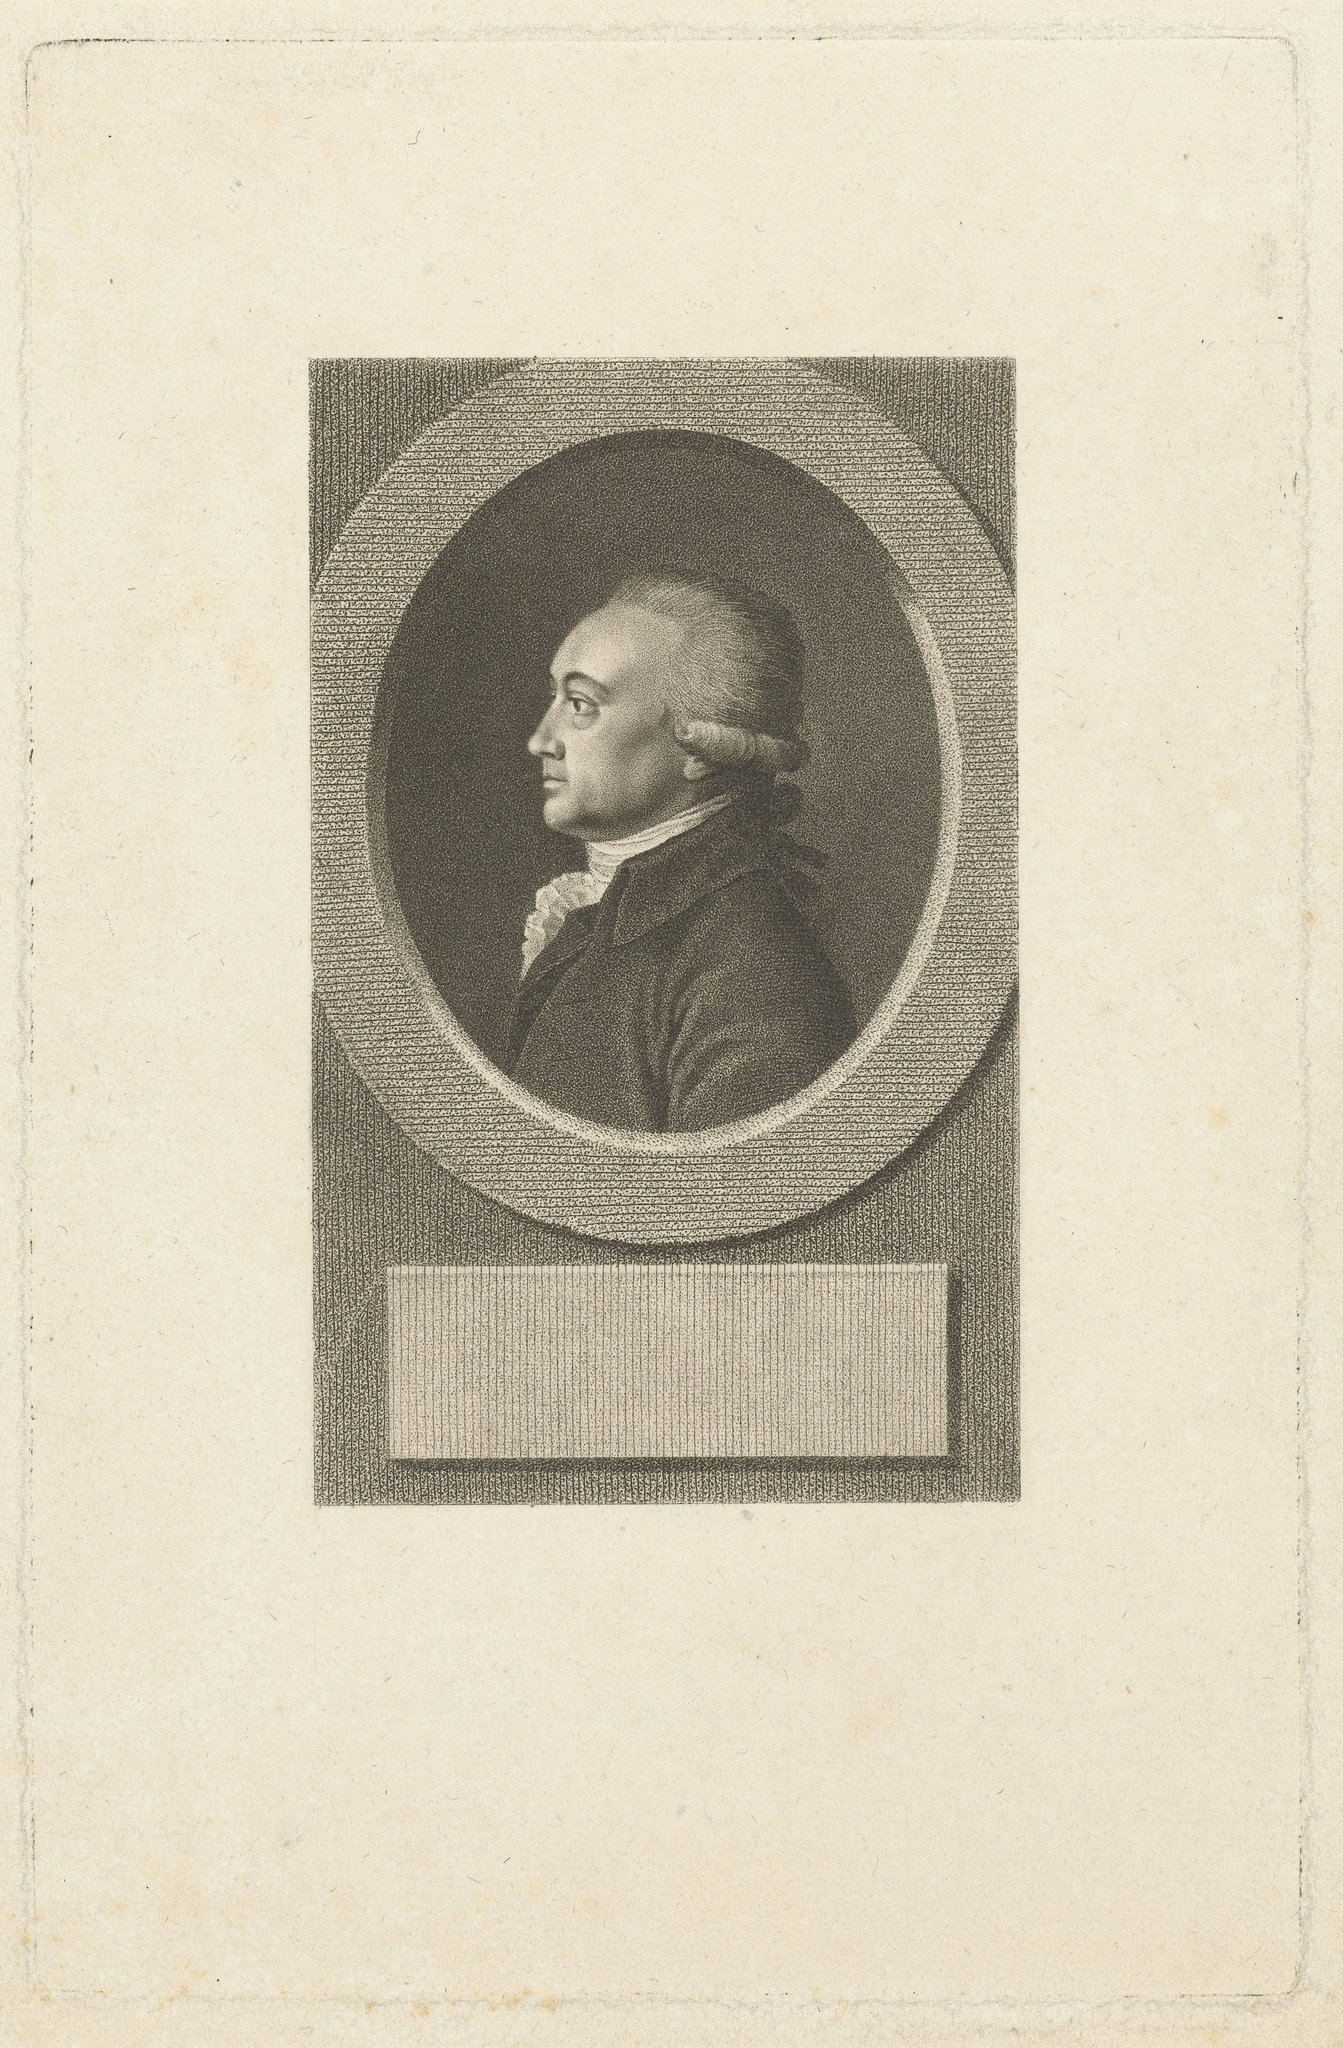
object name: print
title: Portret van Jean-Paul Rabaut Saint-Étienne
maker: lambertus antonius claessens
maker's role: draughtsman, print maker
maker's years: 1763-1834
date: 1792-1808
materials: paper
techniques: engraving, etching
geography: amsterdam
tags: revolutionair, jean-paul rabaut saint-étienne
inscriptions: collector's mark: Lugt 2228